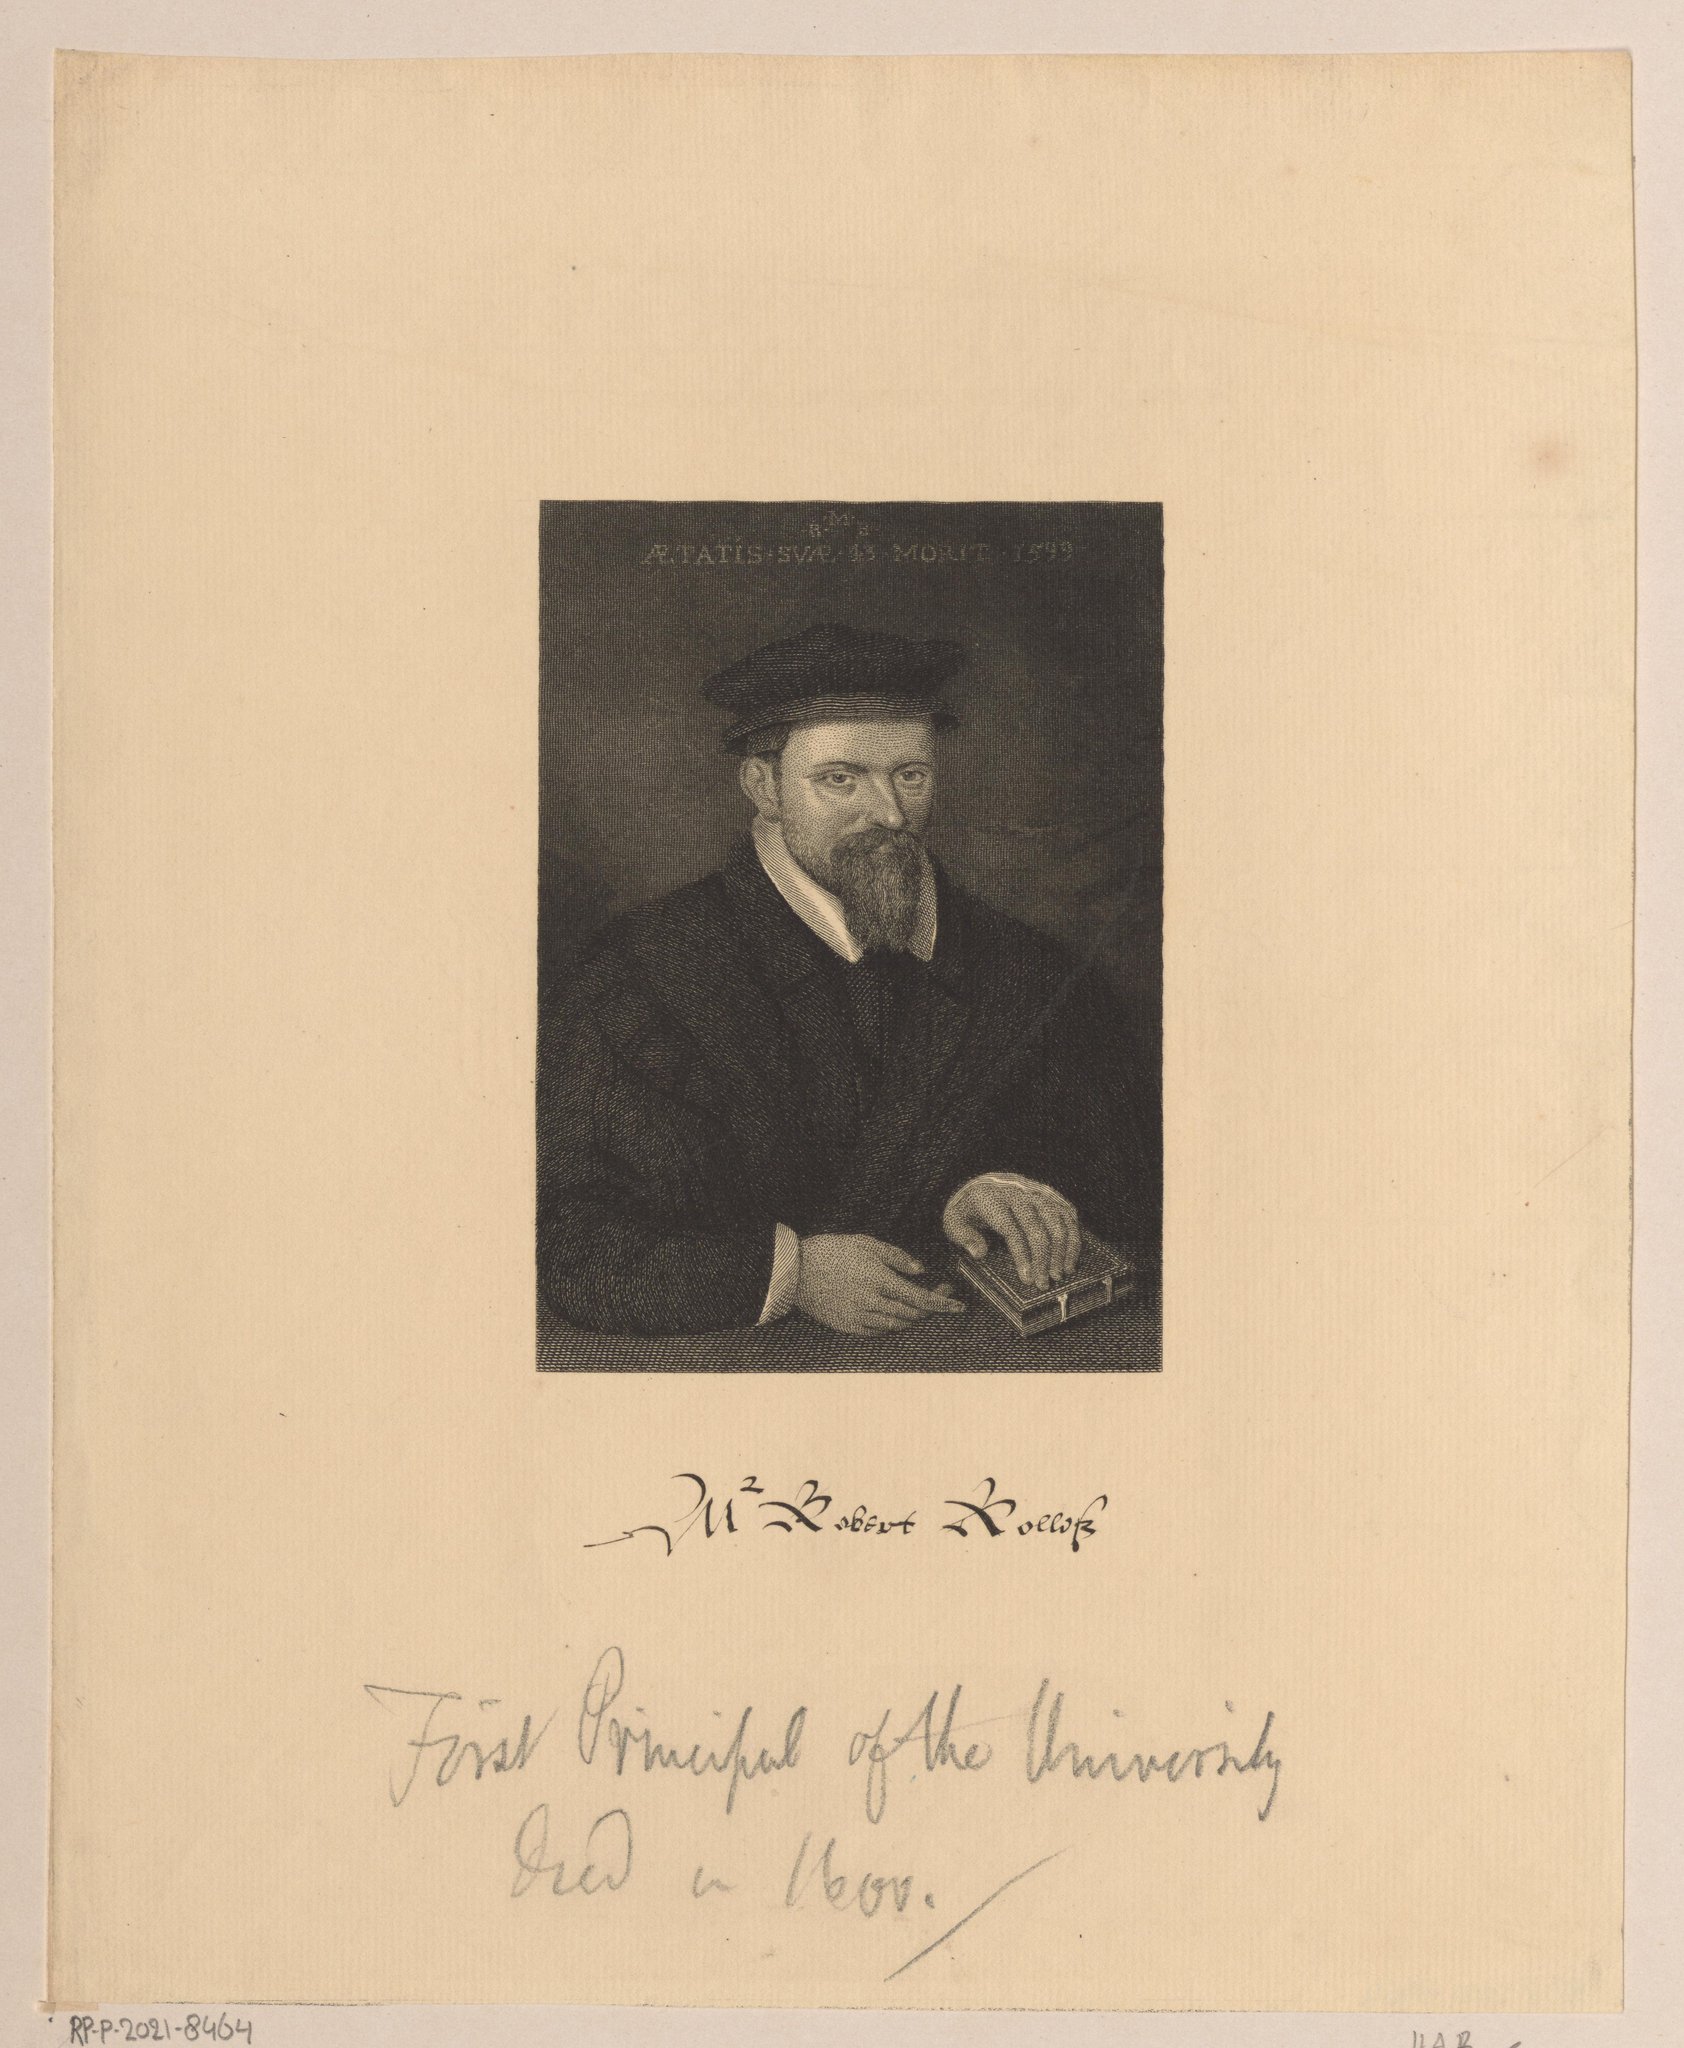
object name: print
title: Portret van Robert Rollock op 43-jarige leeftijd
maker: Anonymous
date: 1800-1899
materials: paper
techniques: engraving, etching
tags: historical persons, book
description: Onder het portret een facsimile van de handtekening van de geportretteerde.